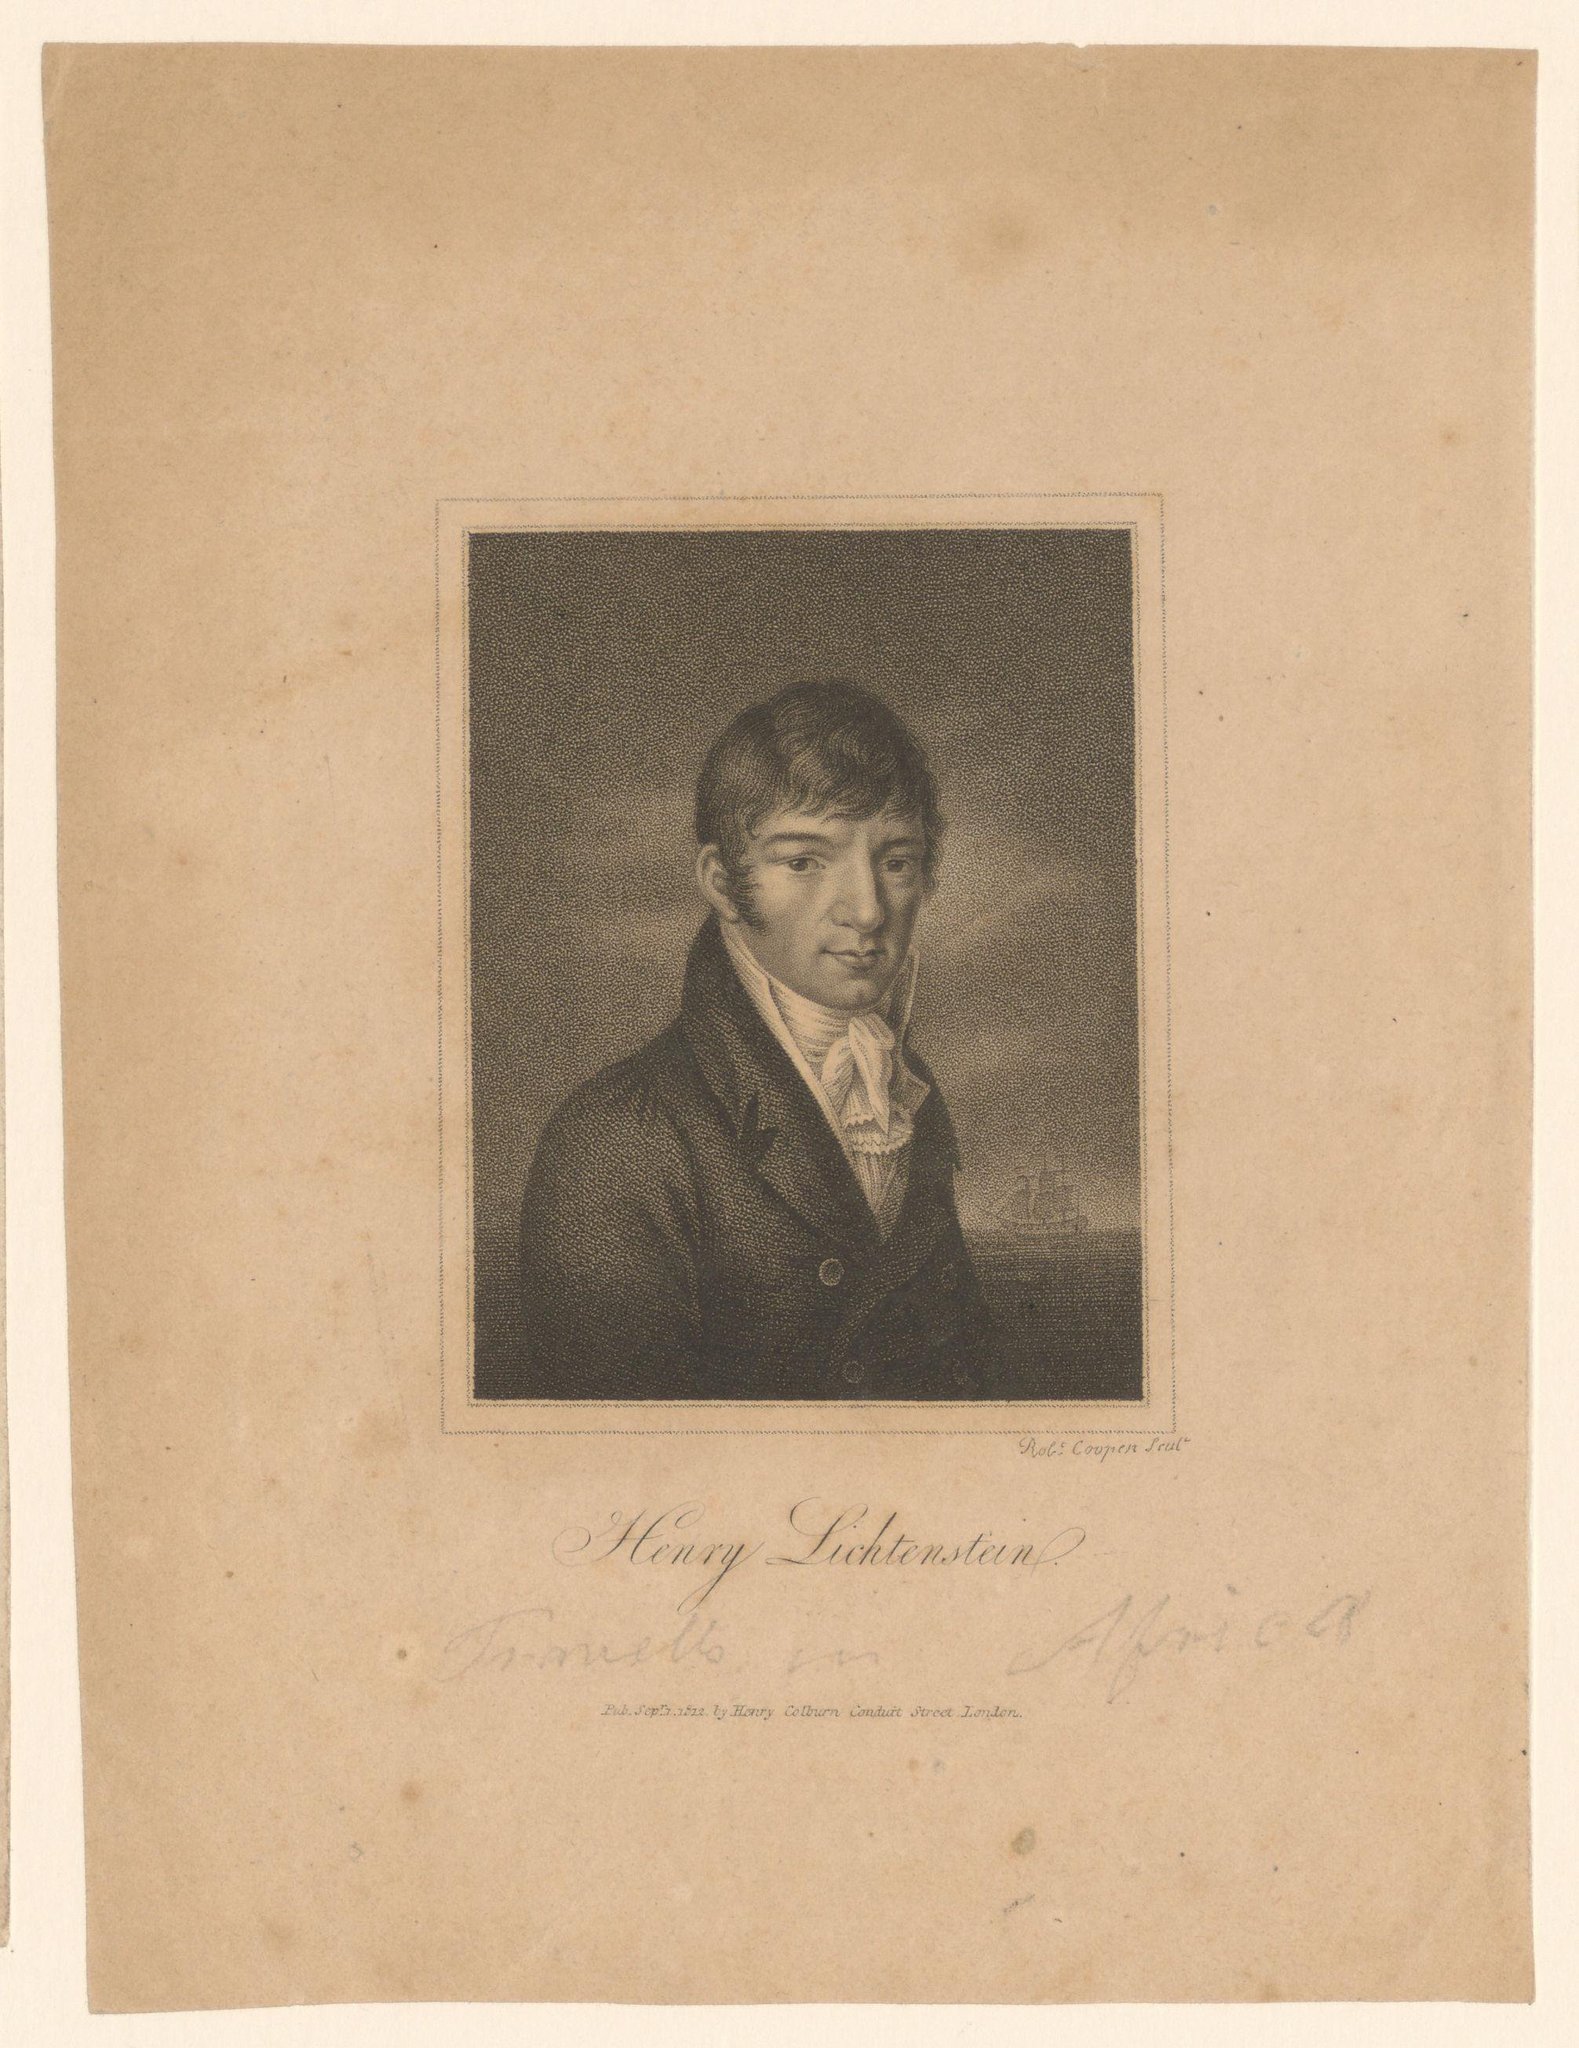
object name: book illustration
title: Portret van Martin Hinrich Lichtenstein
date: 1812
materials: paper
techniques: stippling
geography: england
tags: explorer (+ portrait of scholar, scientist), zoology (+ portrait of scholar, scientist), historical persons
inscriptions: collector's mark: Lugt 2228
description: Prent uit: Lichtenstein, Martin Hinrich. Travels in Southern Africa (...). Londen: Henry Colburn, 1812.